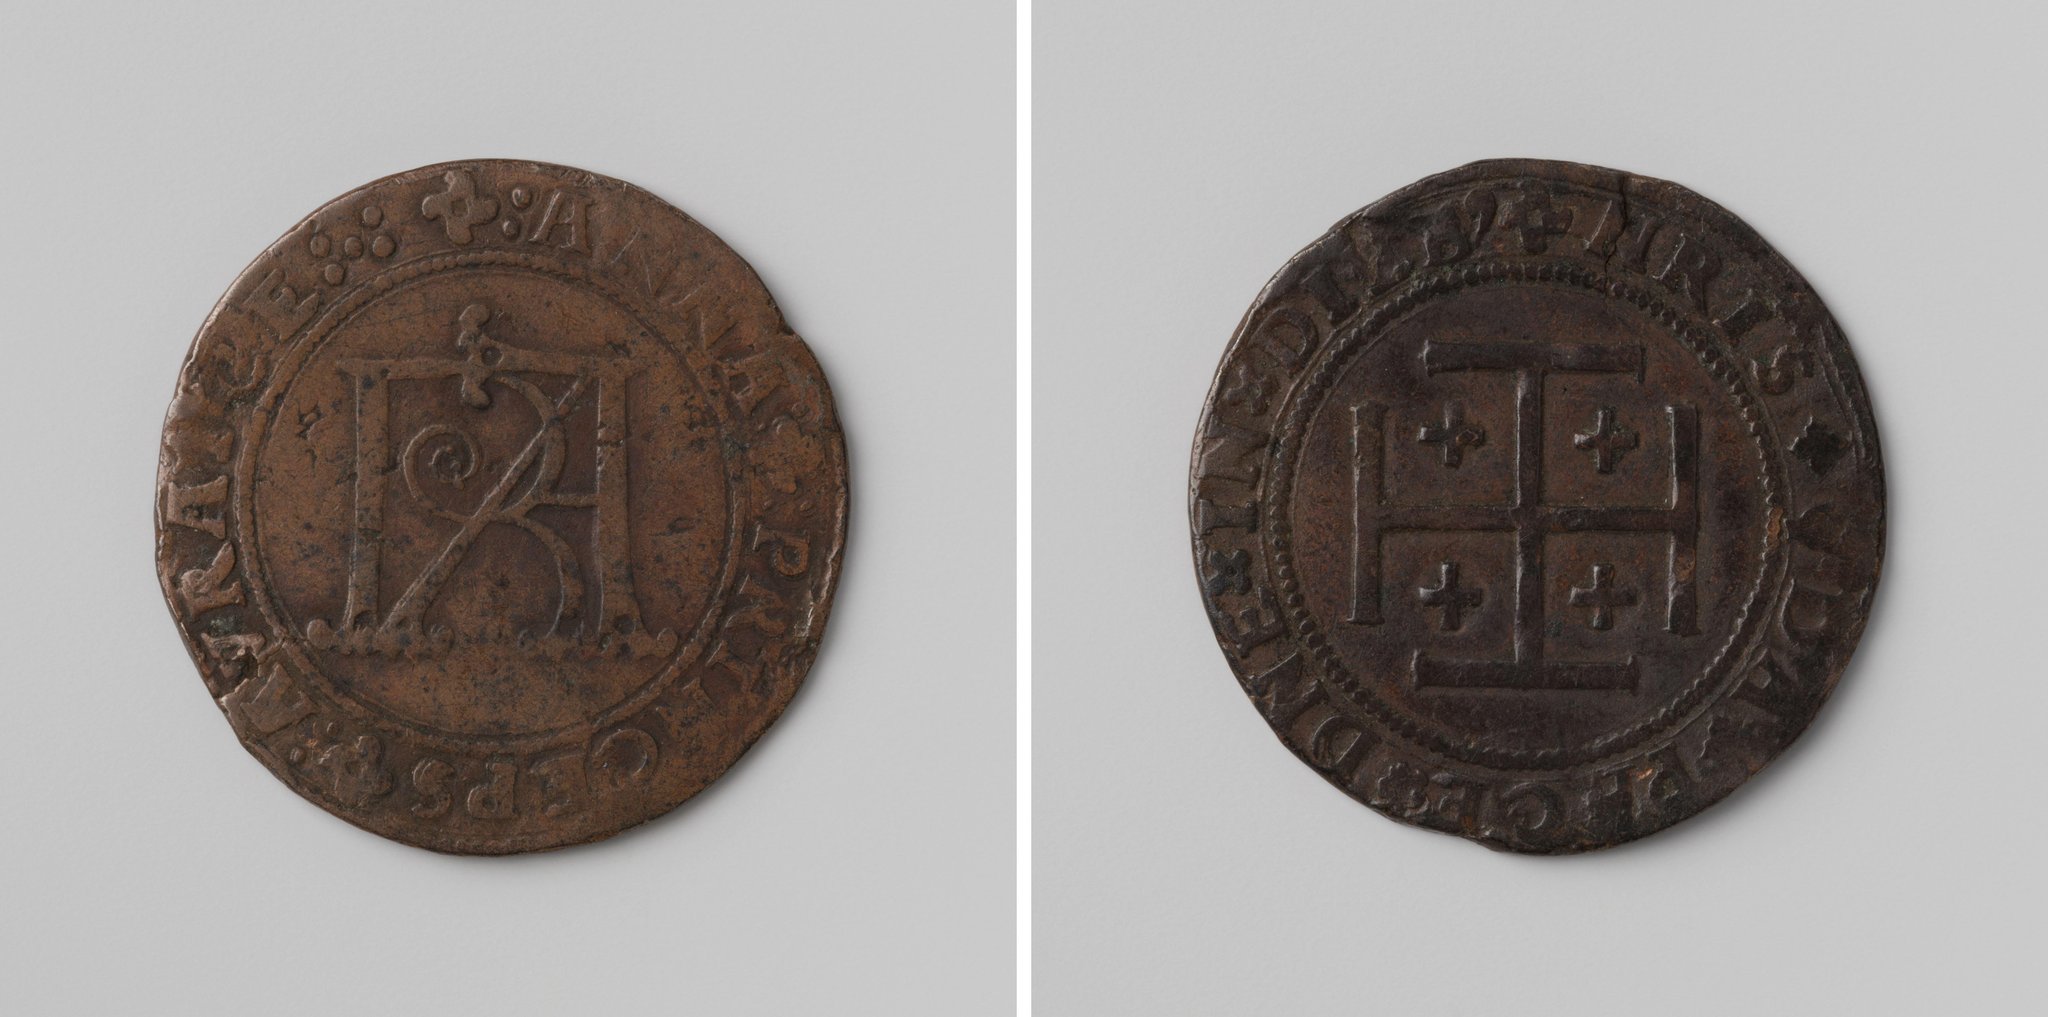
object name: jeton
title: Anna van Lotharingen, hertogin van Aarschot, prinses van Oranje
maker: Anonymous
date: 1576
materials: copper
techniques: striking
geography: antwerp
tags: anna van lotharingen (hertogin van aarschot, prinses van oranje)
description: Koperen penning. Voorzijde: letters A, P en R, verweven tot monogram binnen omschrift. Keerzijde: Jeruzalems kruis binnen omschrift